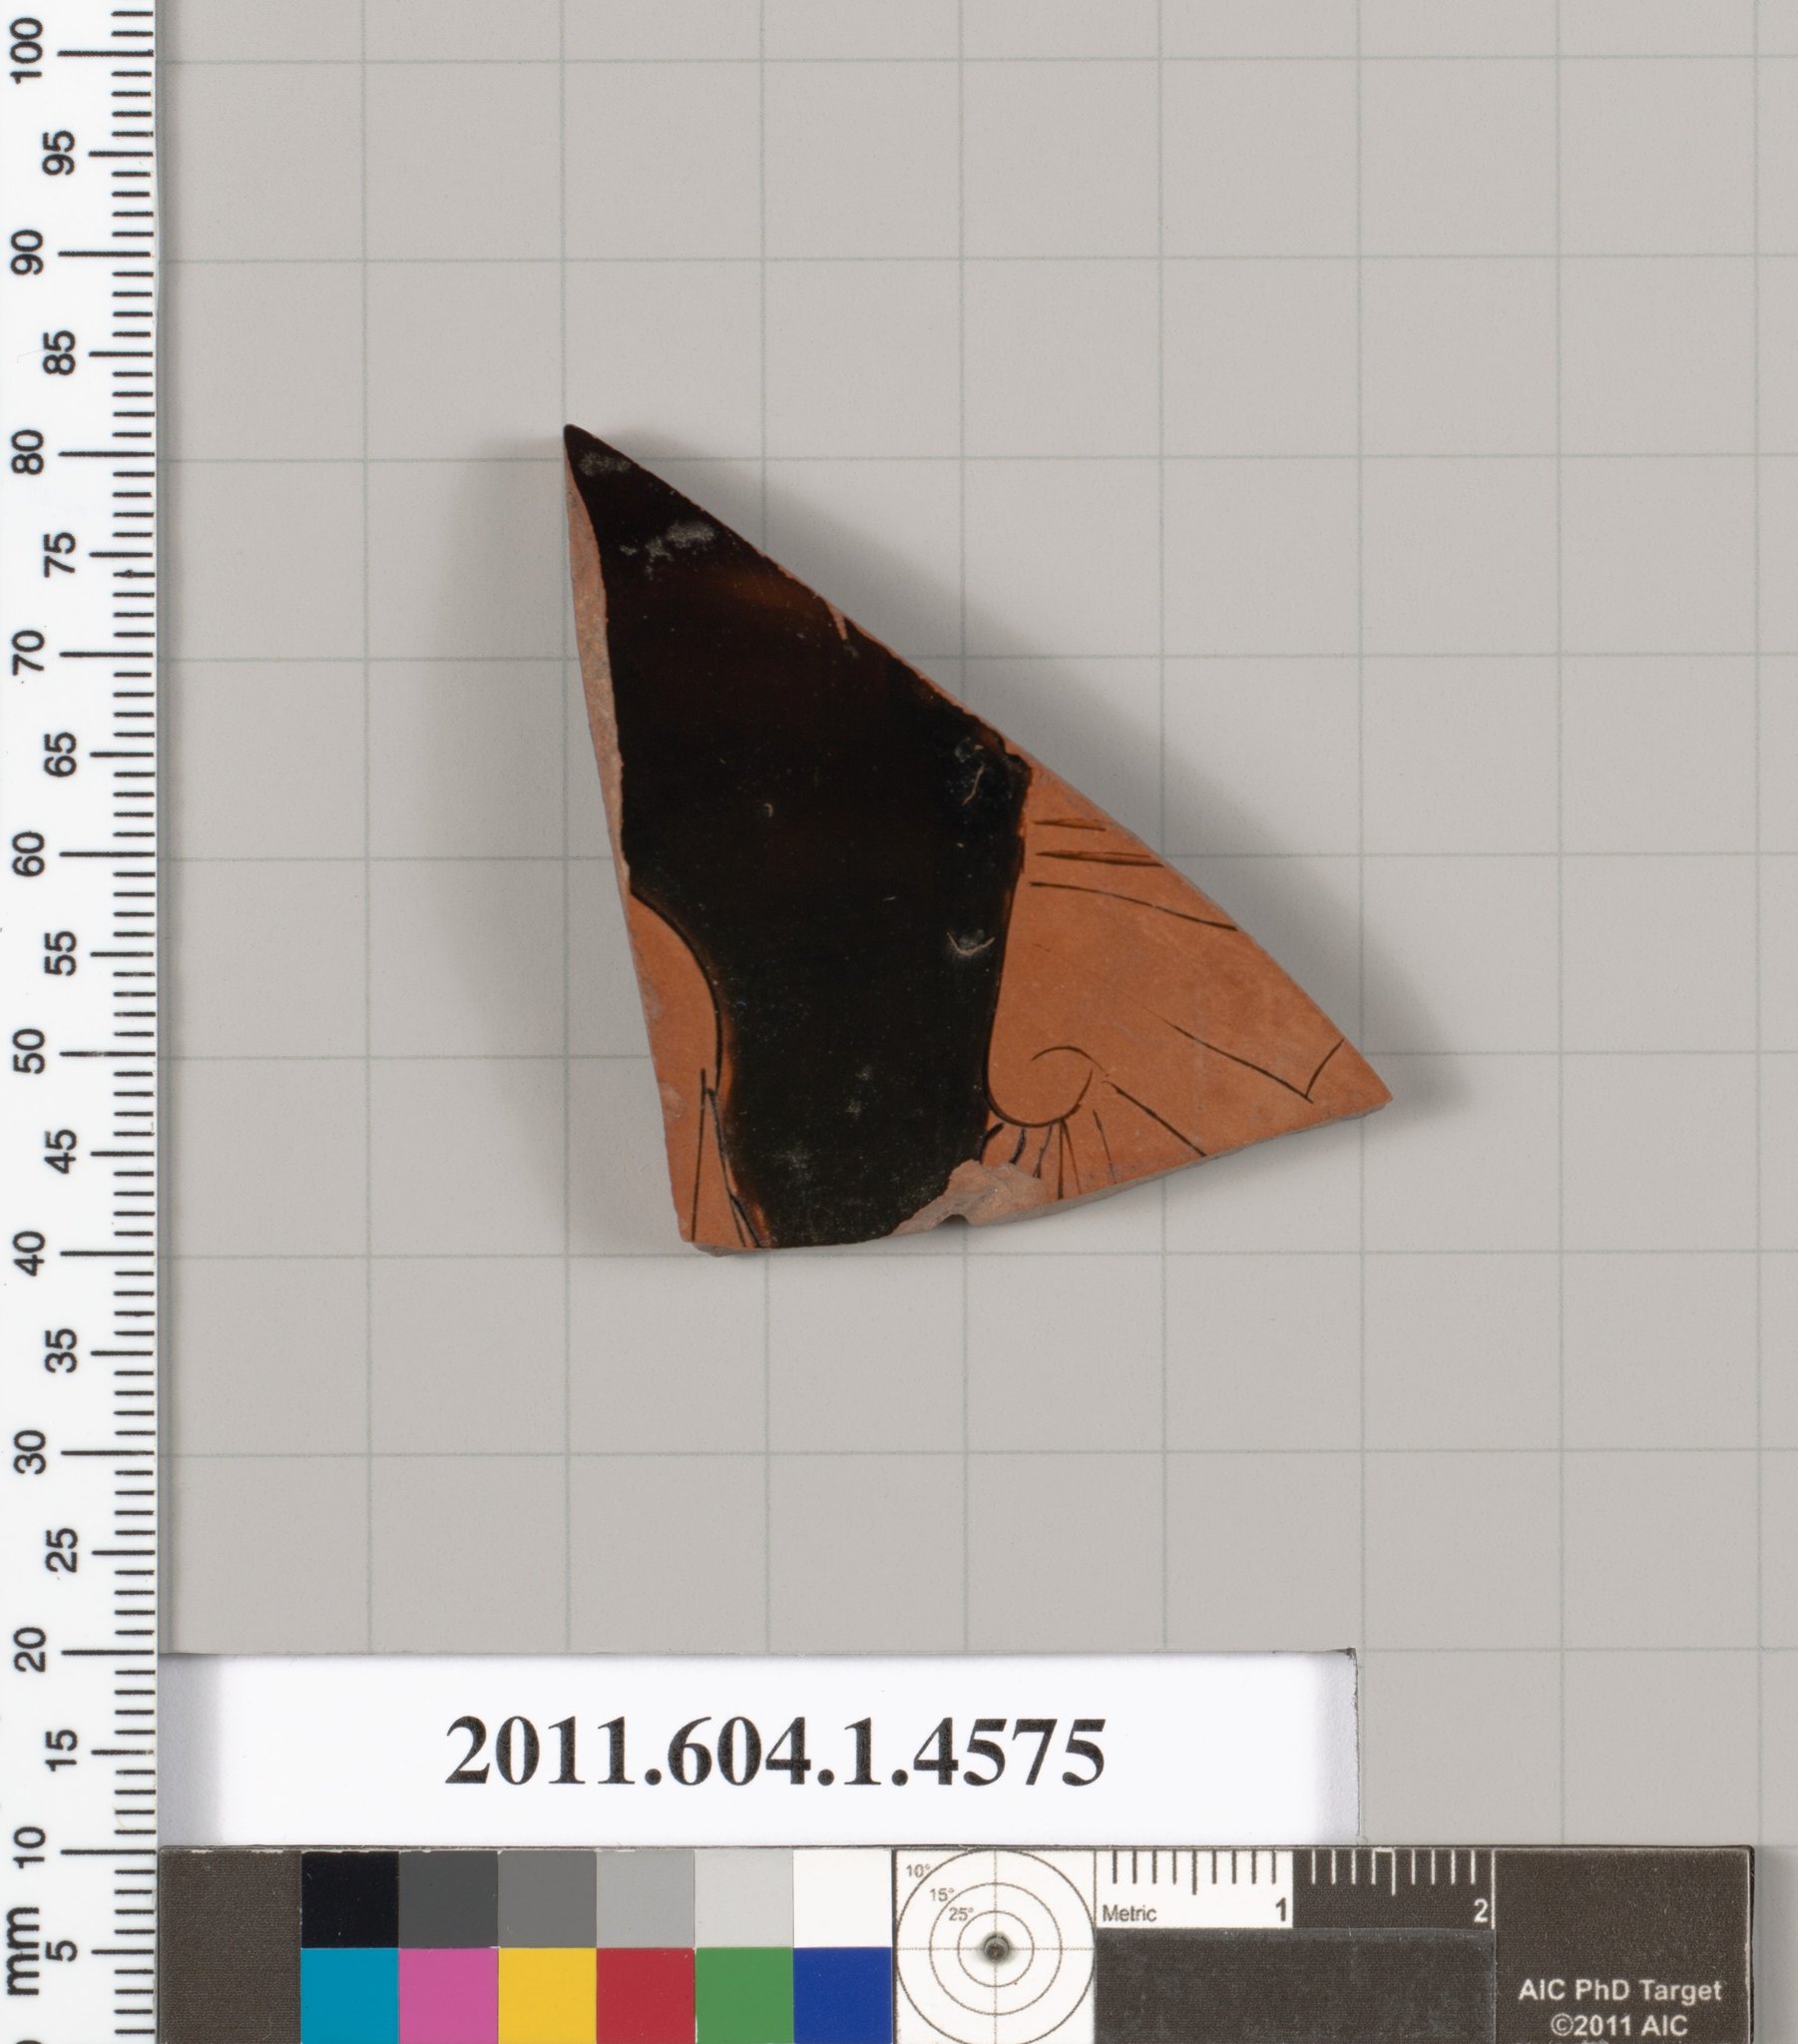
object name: kylix fragment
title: Terracotta fragment of a kylix (drinking cup)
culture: greek, attic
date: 500-470 BCE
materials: terracotta